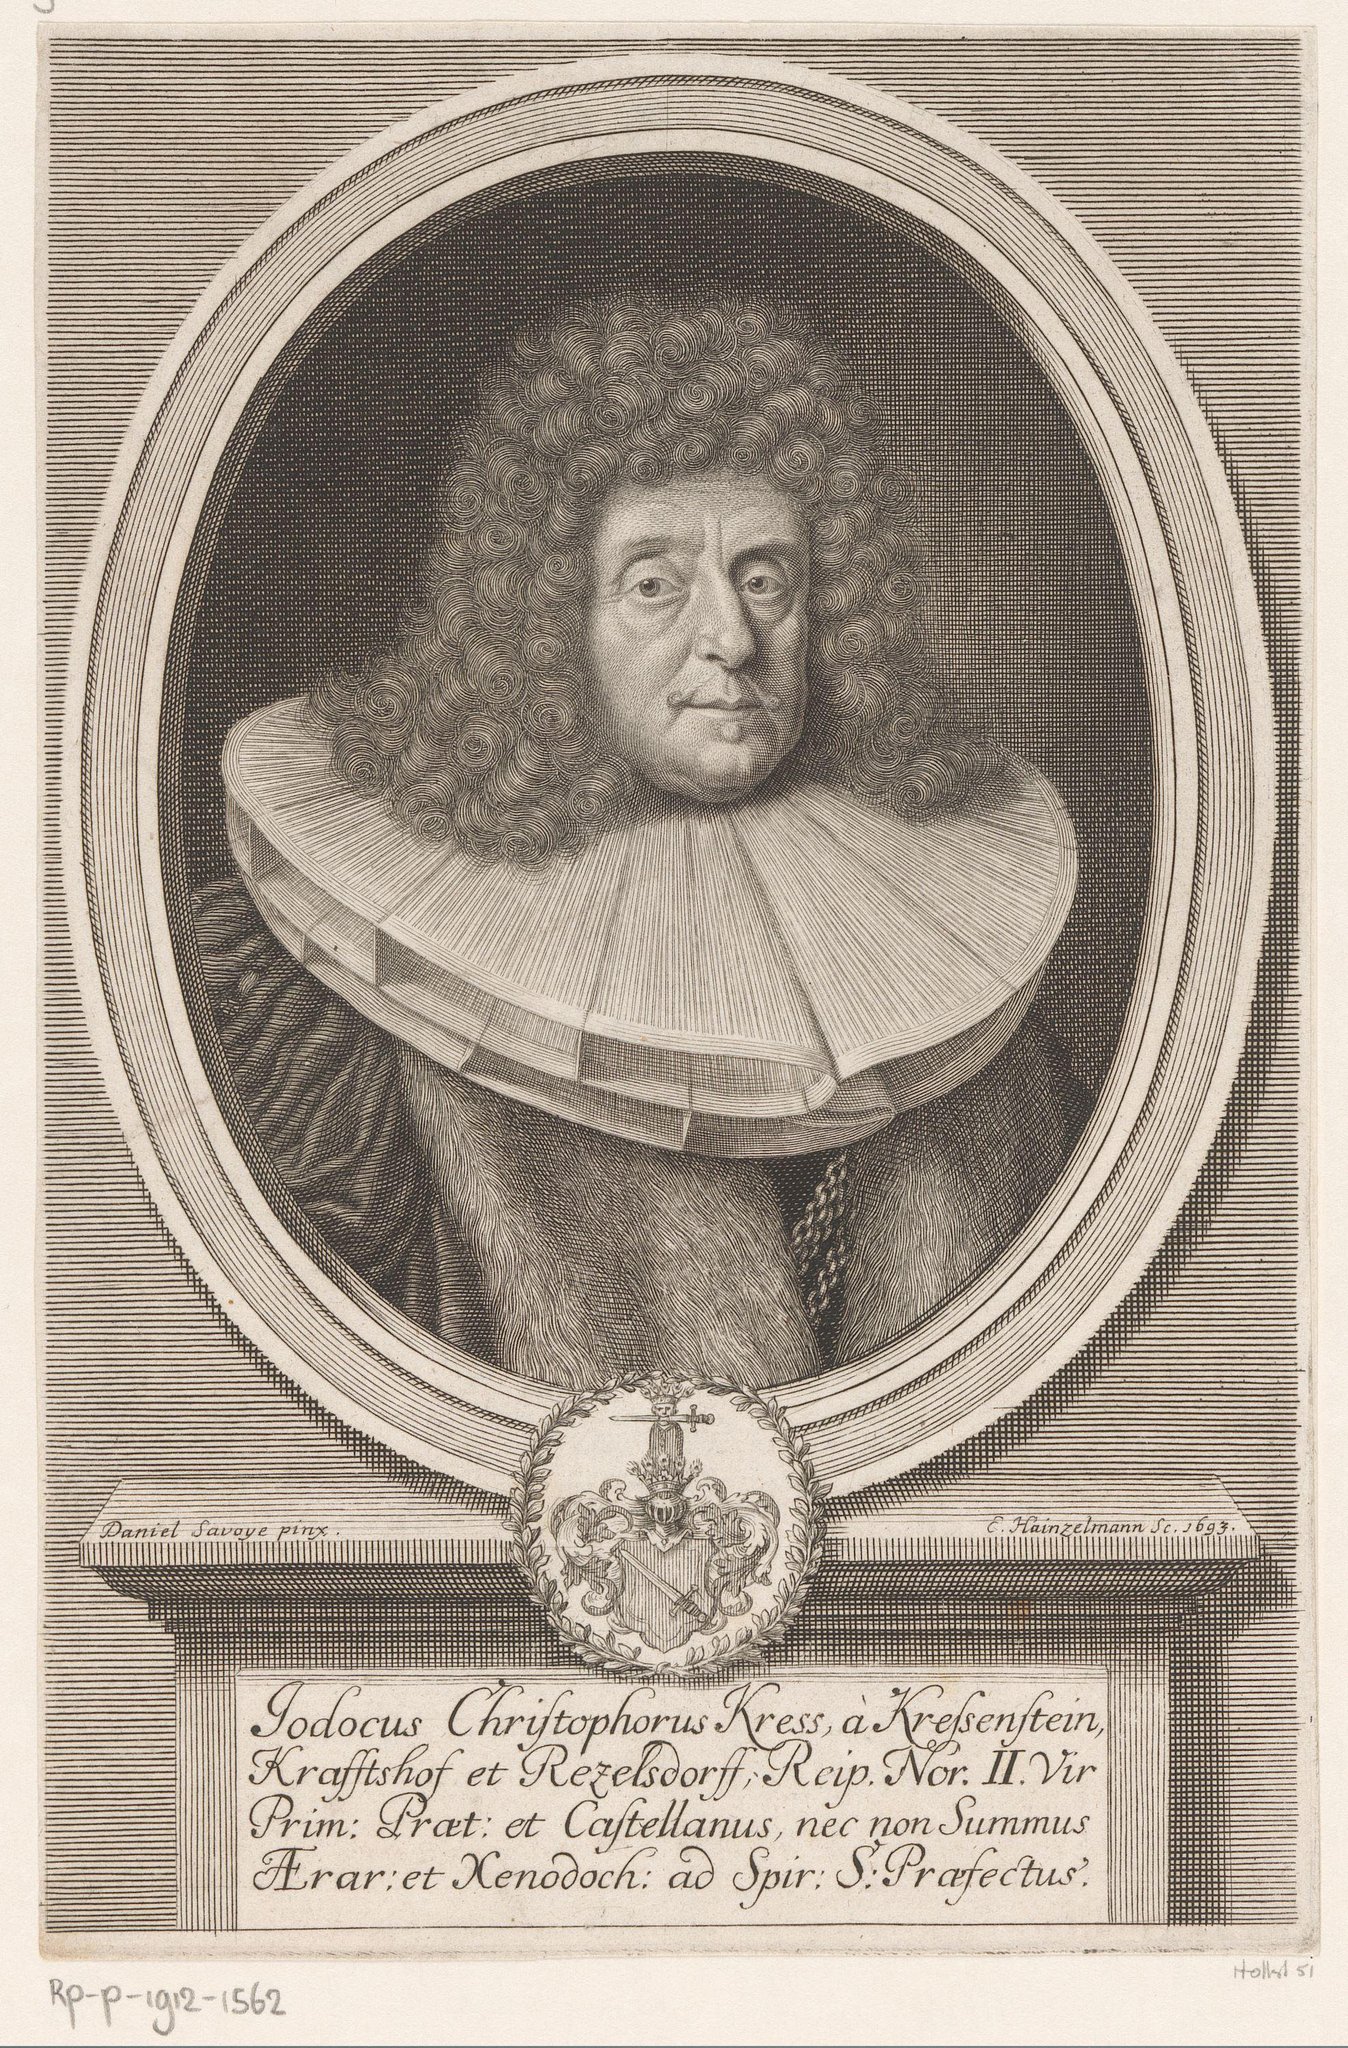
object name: print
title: Portret van Jobst Christoph Kress von Kressenstein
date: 1693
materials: paper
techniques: engraving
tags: historical persons, armorial bearing, heraldry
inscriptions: collector's mark: Lugt 2228